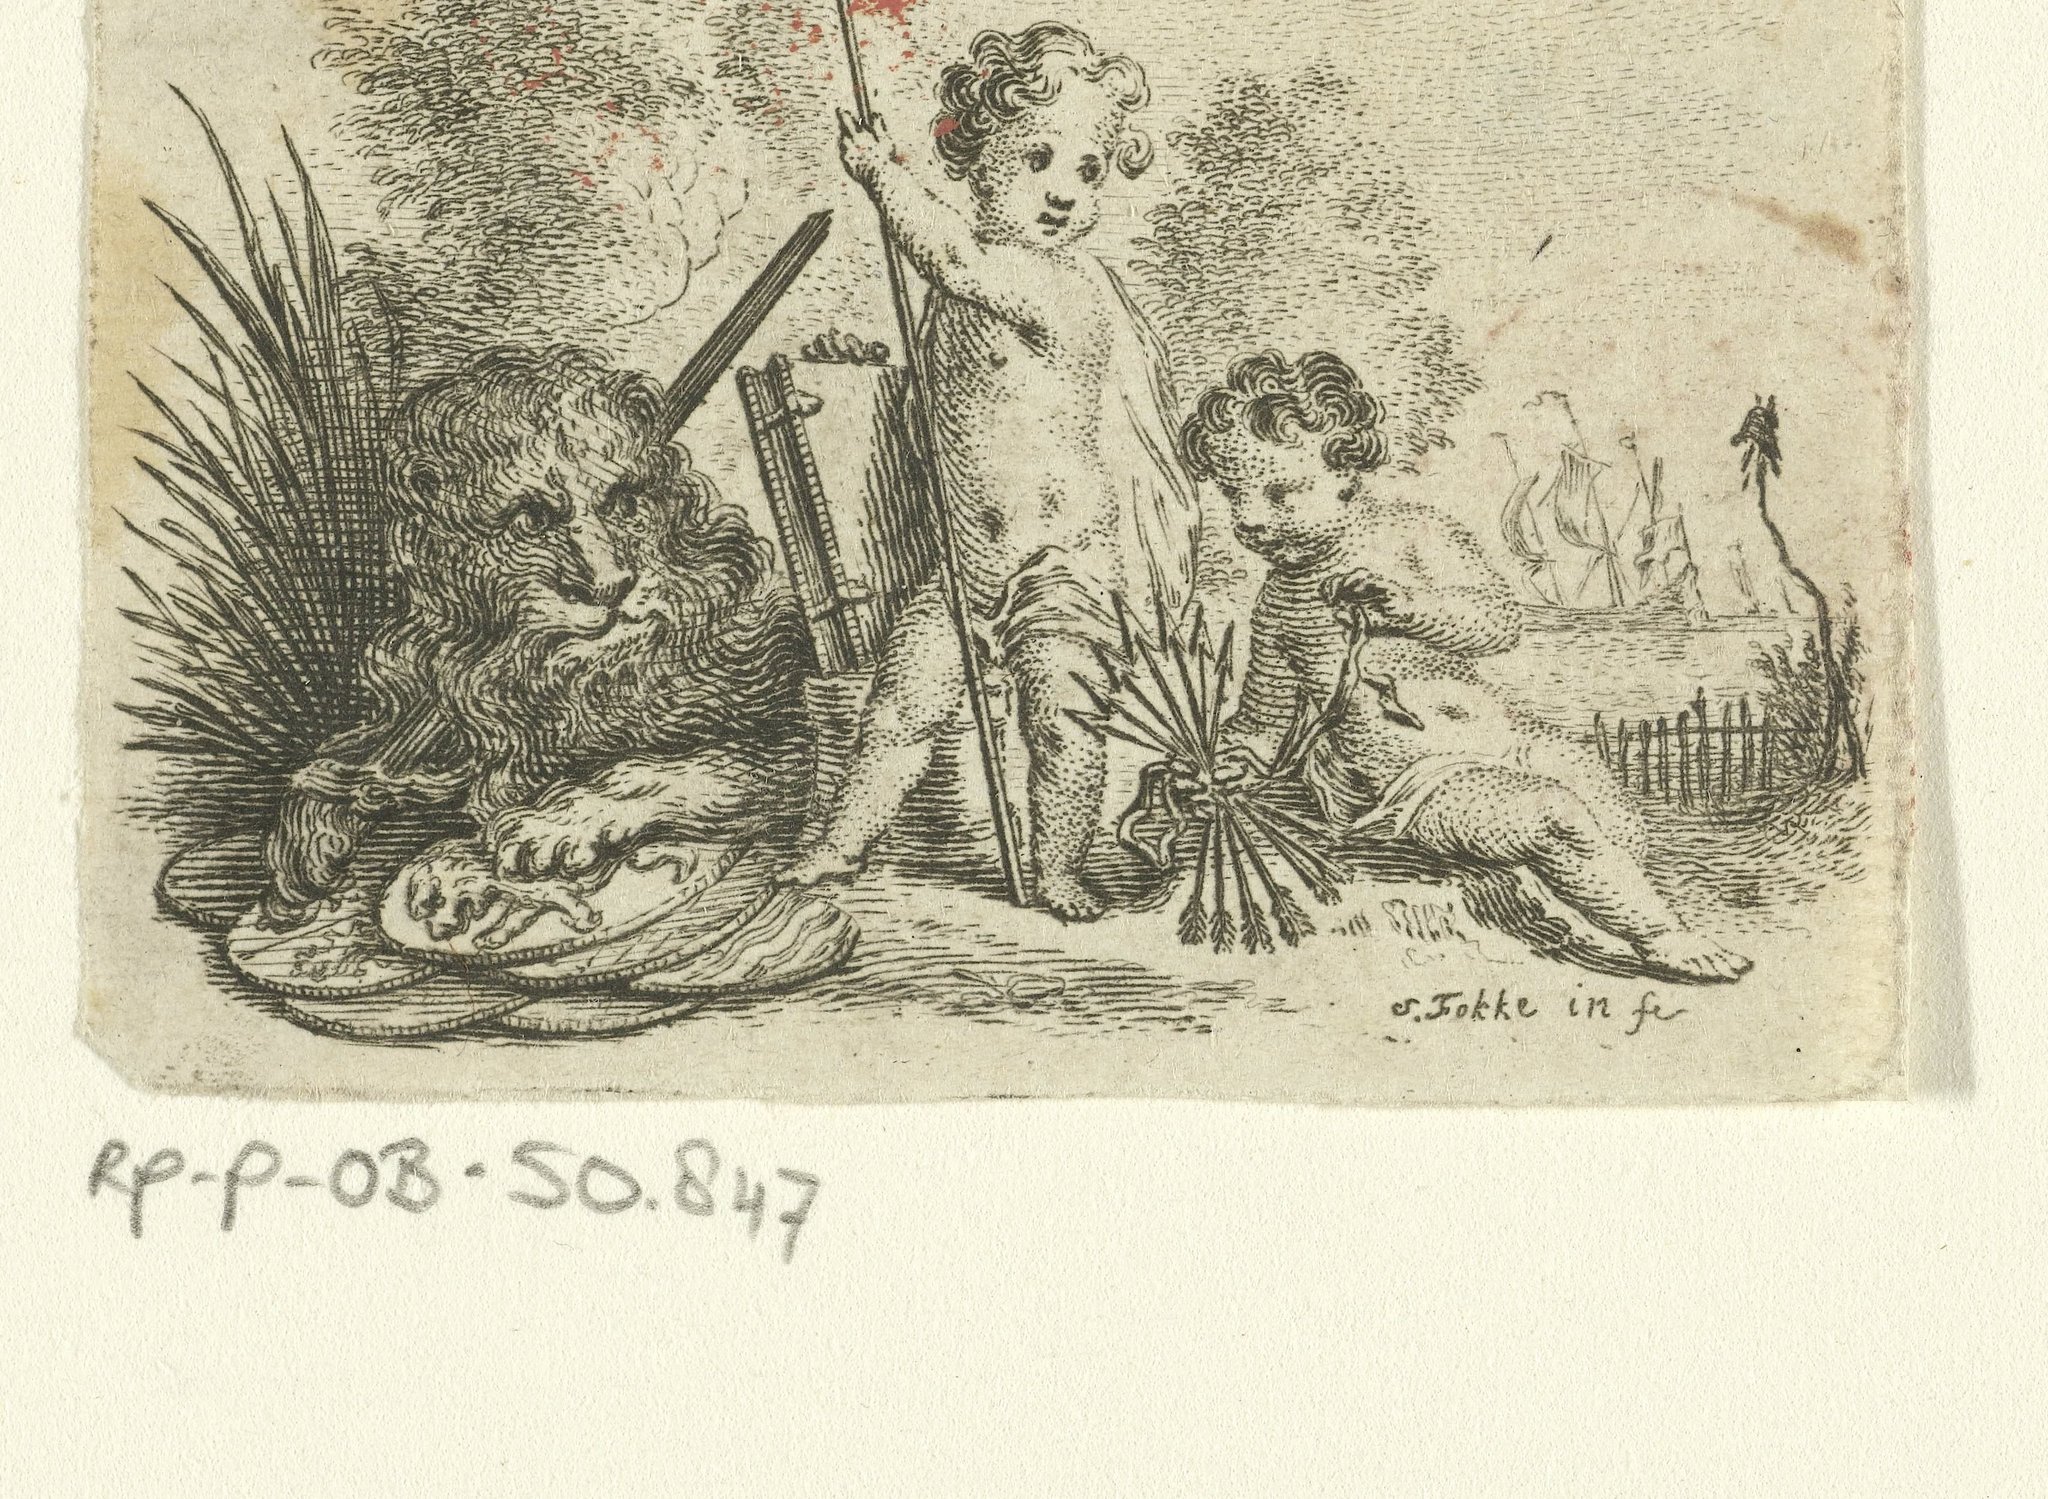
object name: print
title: Vignet met de Nederlandse leeuw en twee putti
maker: simon fokke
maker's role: draughtsman, print maker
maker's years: 1712-1784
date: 1722-1784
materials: paper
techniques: etching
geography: amsterdam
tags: freedom, liberty; 'libertà' (ripa), beasts of prey, predatory animals: lion, cupids: 'amores', 'amoretti', 'putti'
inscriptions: collector's mark: Lugt 240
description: De Nederlandse leeuw laat al liggend zijn poot rusten op een stapel wapenschilden en houdt in zijn andere poot een zwaard vast. Naast hem draagt een putto een boek en een hoed op stok. De tweede putto heeft een bundel met zeven samengebonden pijlen in zijn handen.